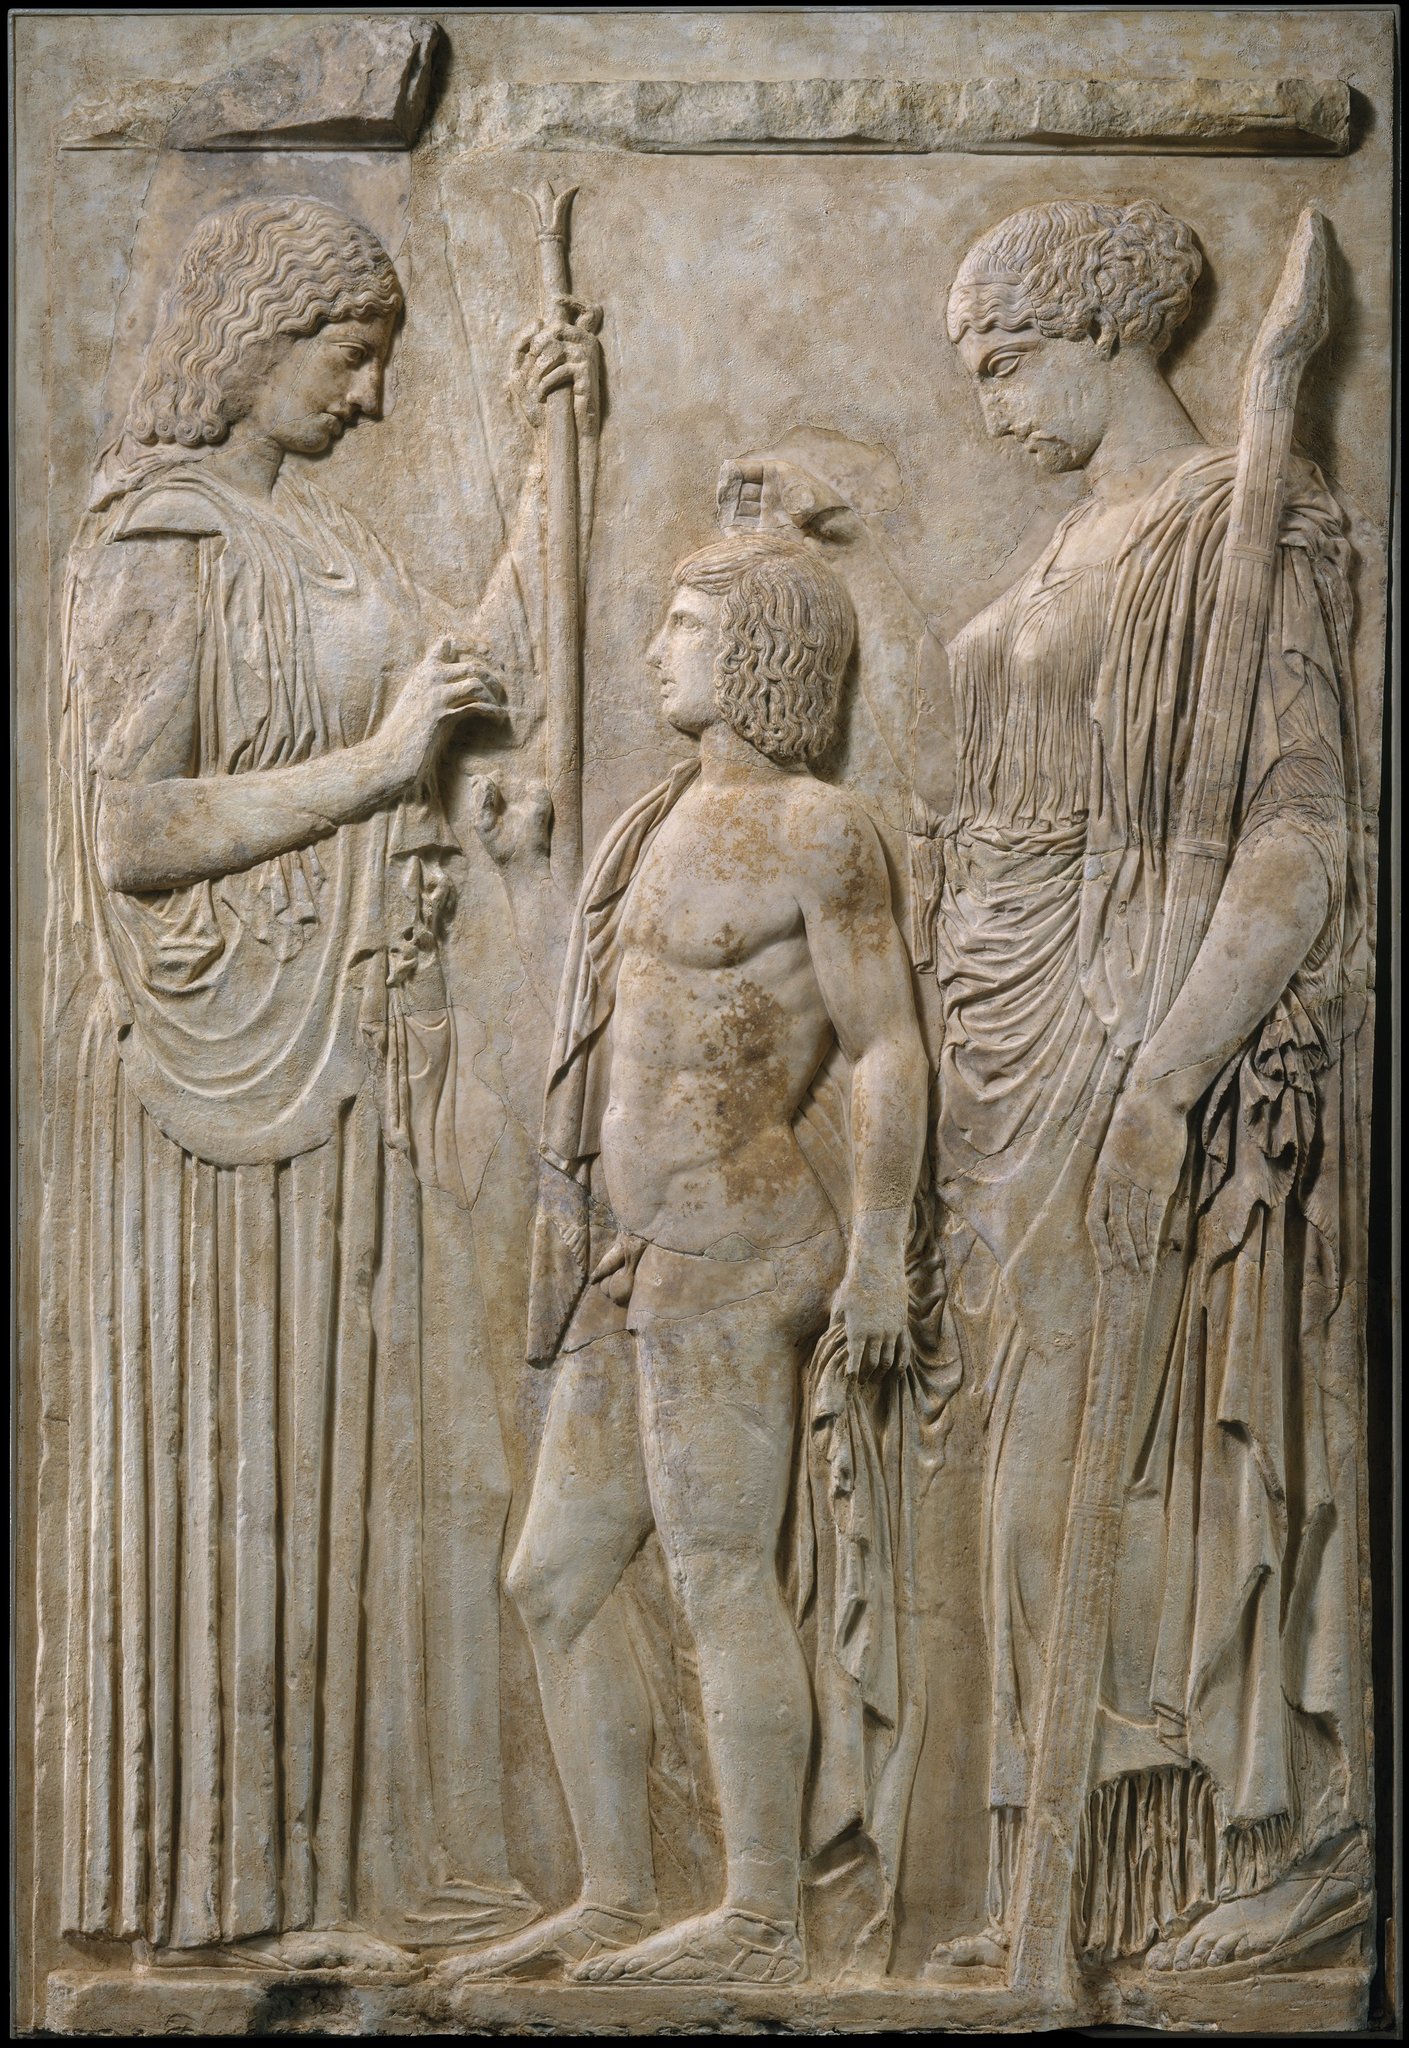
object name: relief fragment from the great eleusinian relief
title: Ten marble fragments of the Great Eleusinian Relief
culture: roman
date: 27 BCE-14 CE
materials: marble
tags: male nudes,women,persephone,demeter